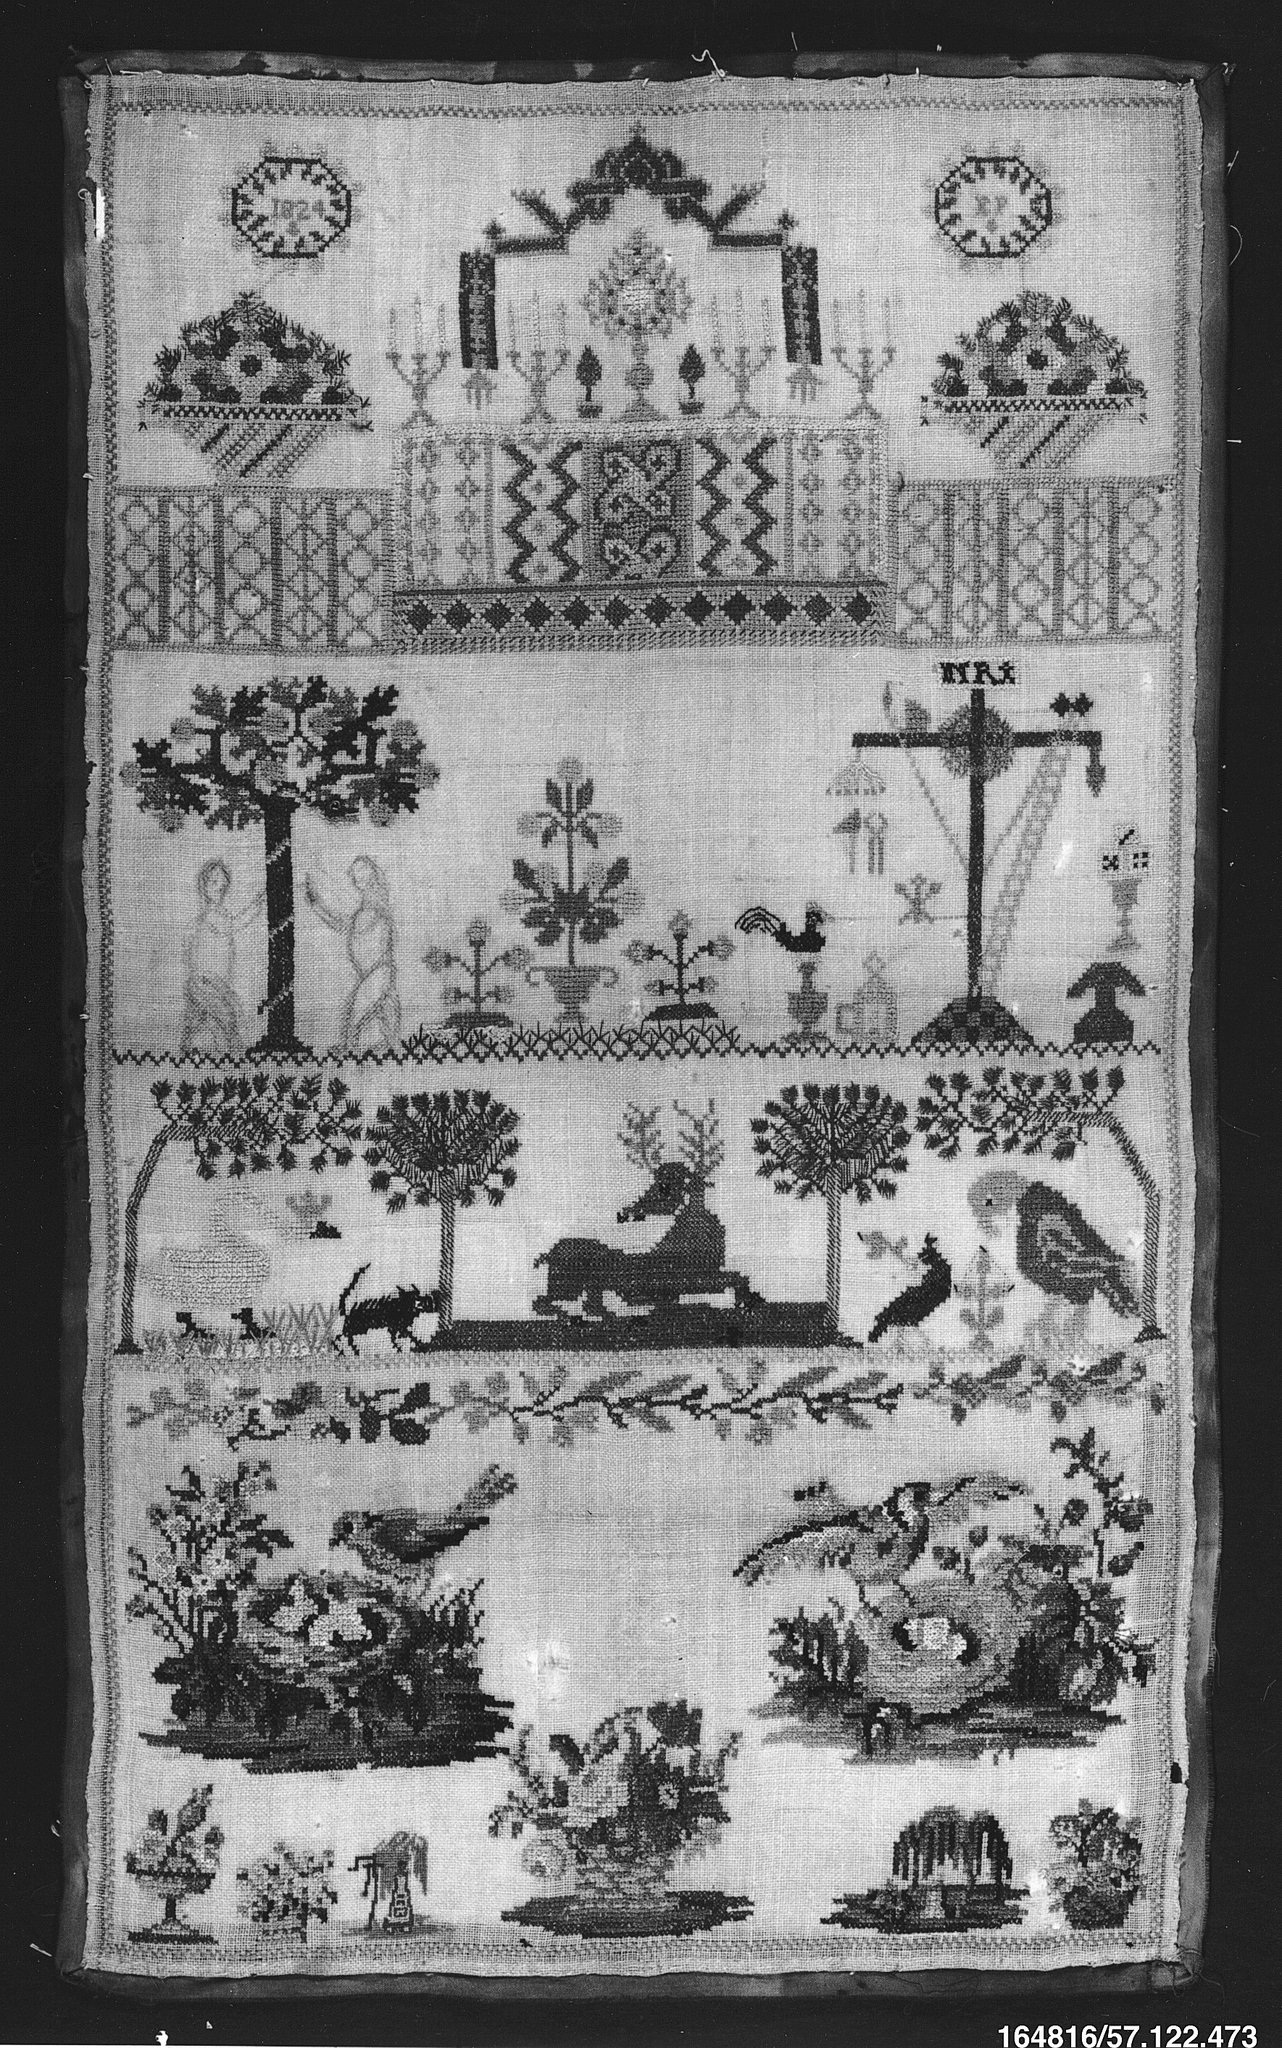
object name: sampler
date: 1824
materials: canvas, silk, wool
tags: human figures,birds,deer